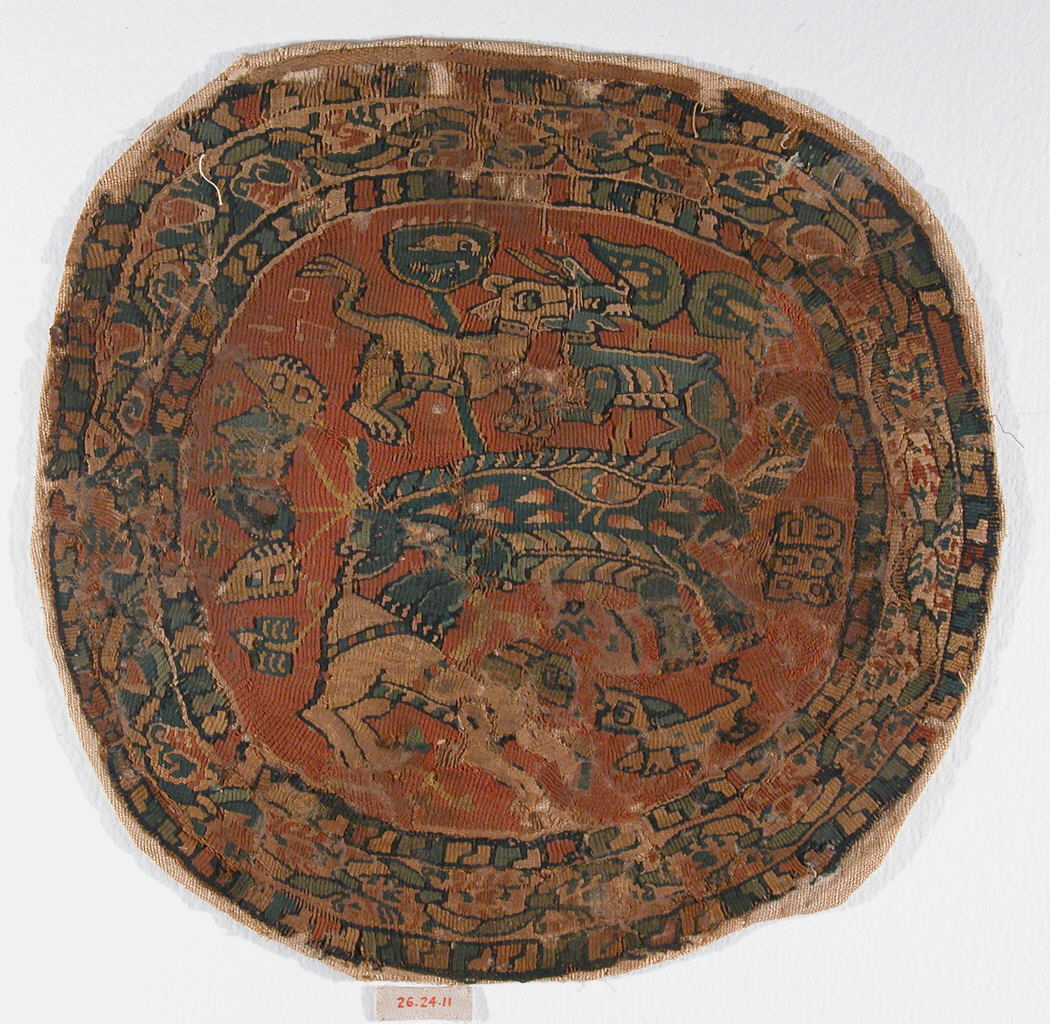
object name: roundel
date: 501-700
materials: linen, wool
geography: egypt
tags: animals